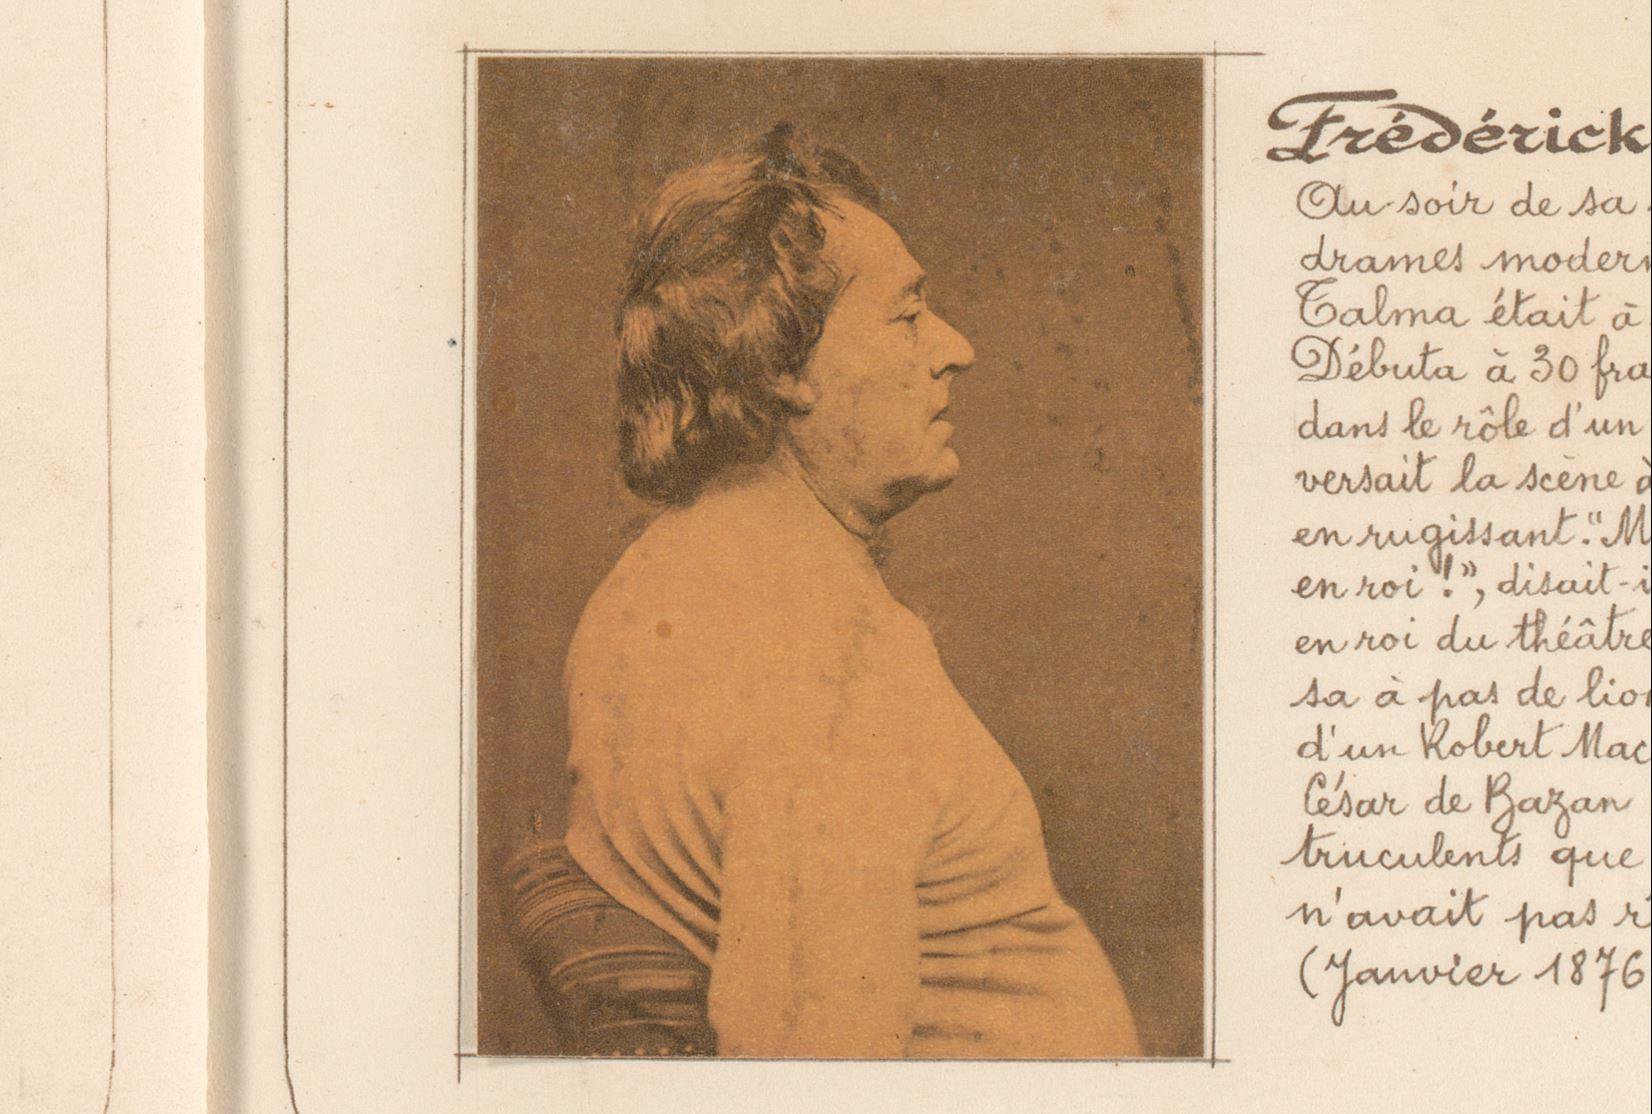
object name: album leaf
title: Portret van Frédérick Lemaître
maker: Anonymous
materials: paper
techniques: rotogravure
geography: france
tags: portrait of actor, actress, france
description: Deze prent maakt deel uit van een album.